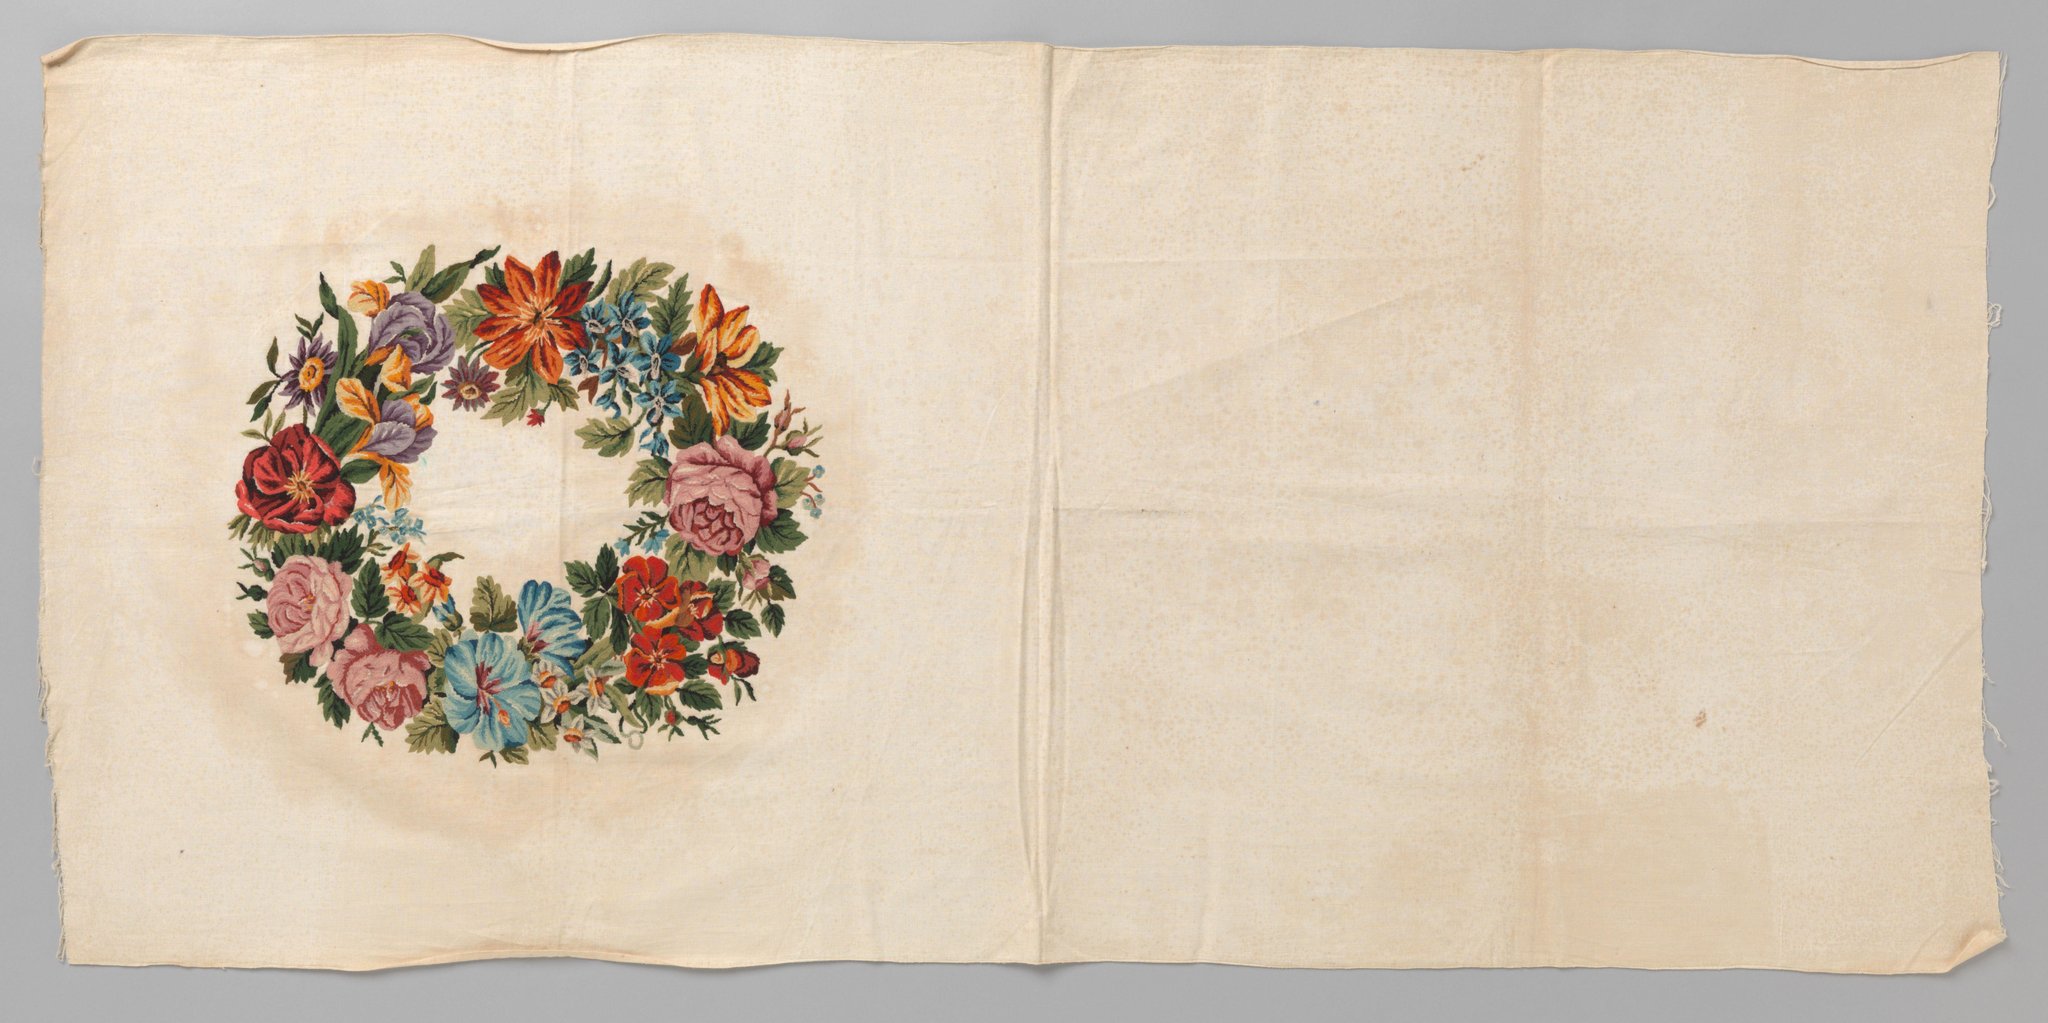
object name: bekledingsstof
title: Metrage bekledingsstof met borduurwerk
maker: Anonymous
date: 1850-1949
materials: cotton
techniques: weave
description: Metrage bekledingsstof, geborduurd met kleurige bloemenkransen in kettingsteek.